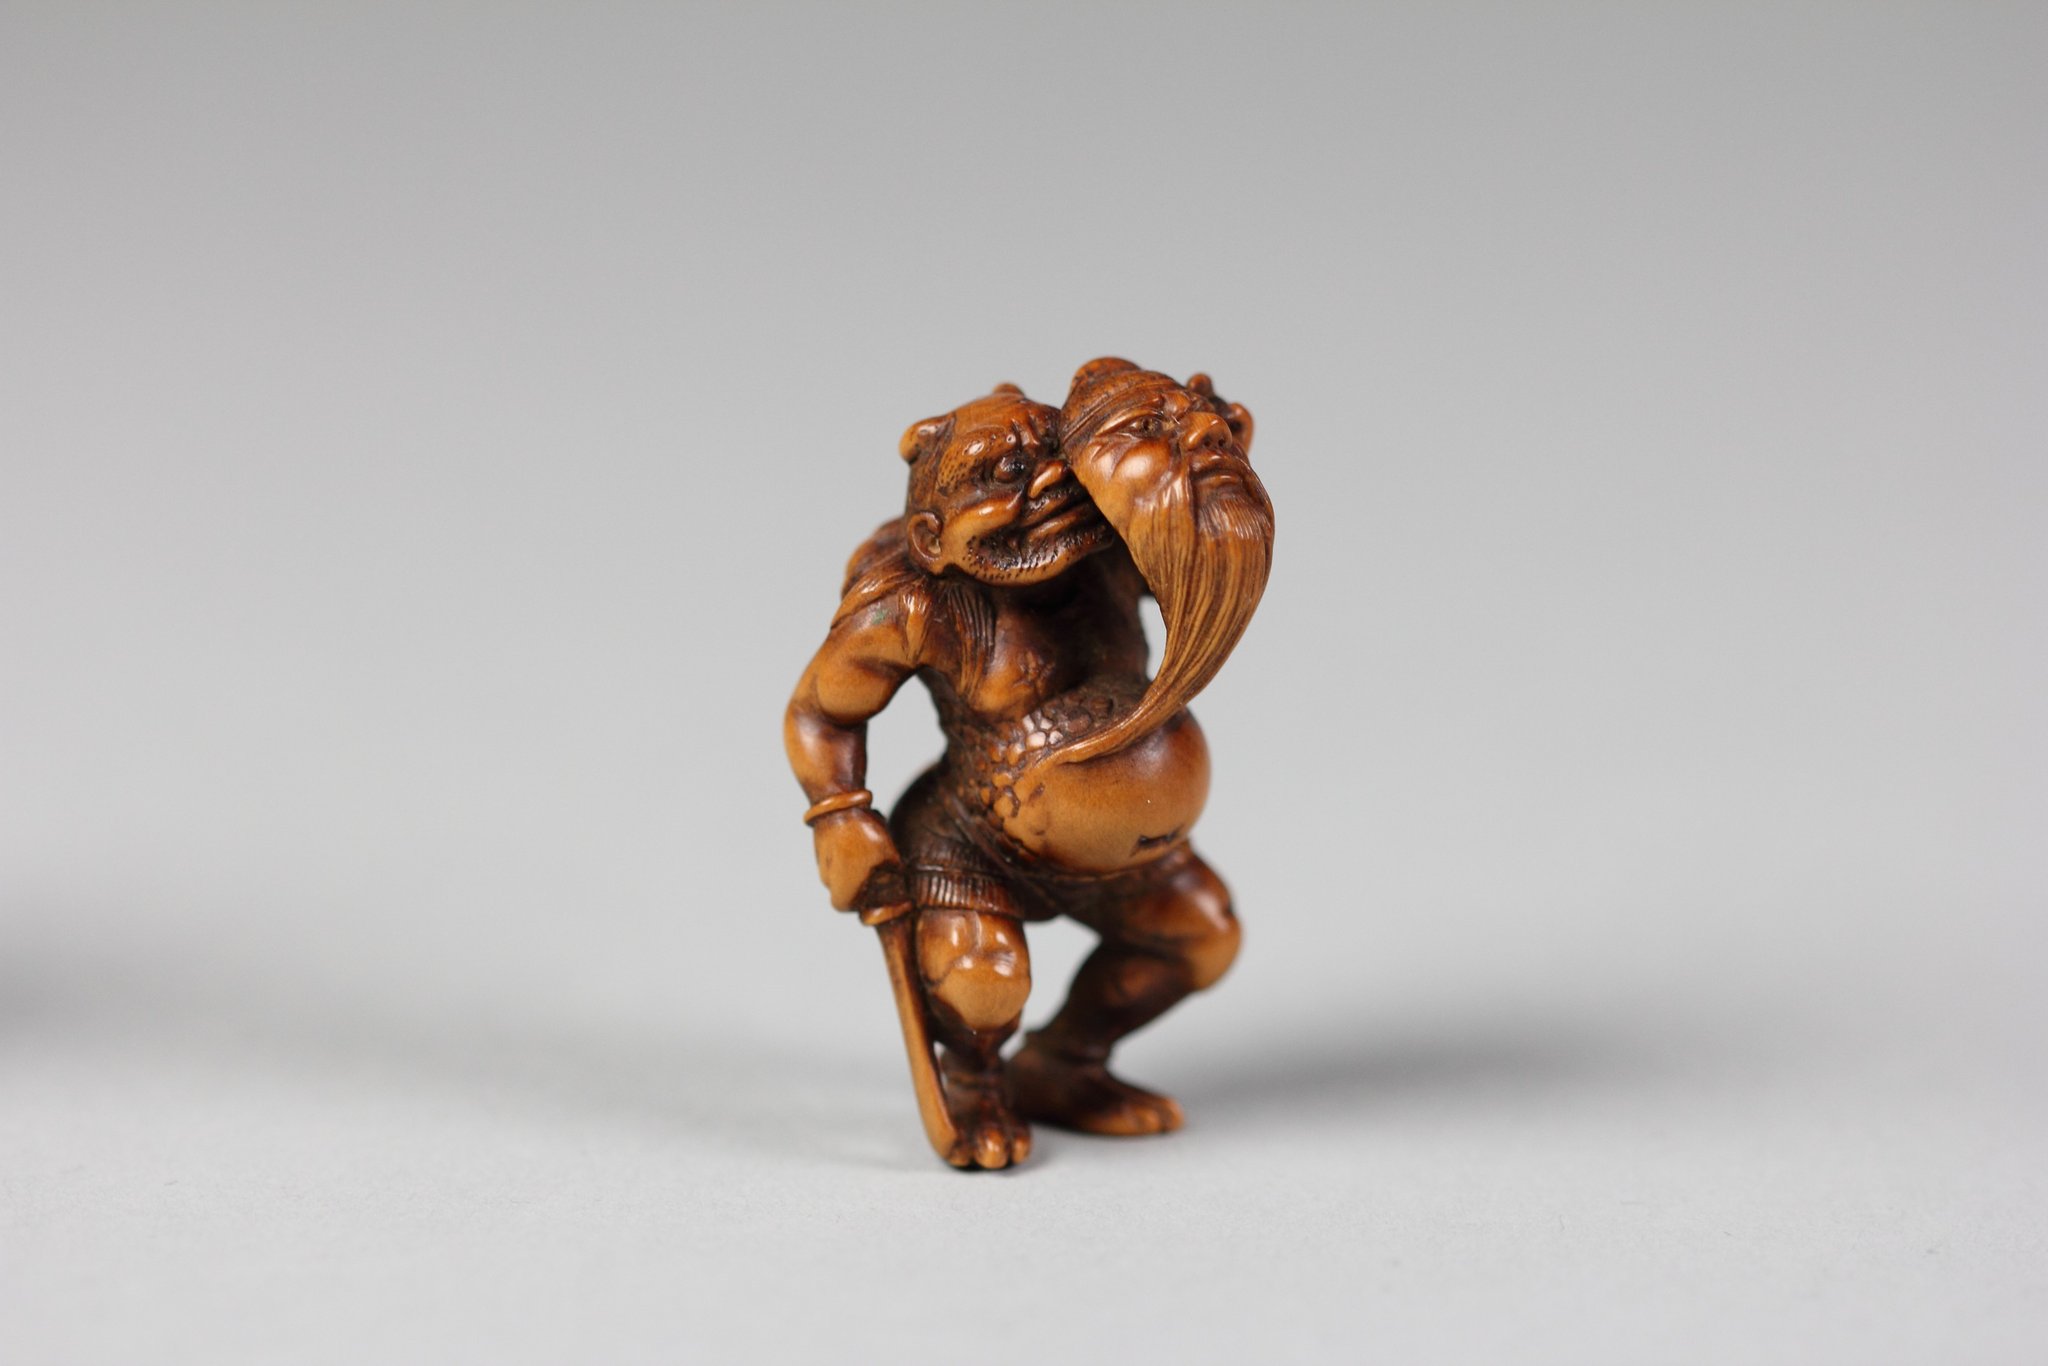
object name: netsuke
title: Netsuke of Demon with a Mask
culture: japanese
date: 1701-1800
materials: wood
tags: masks,demons